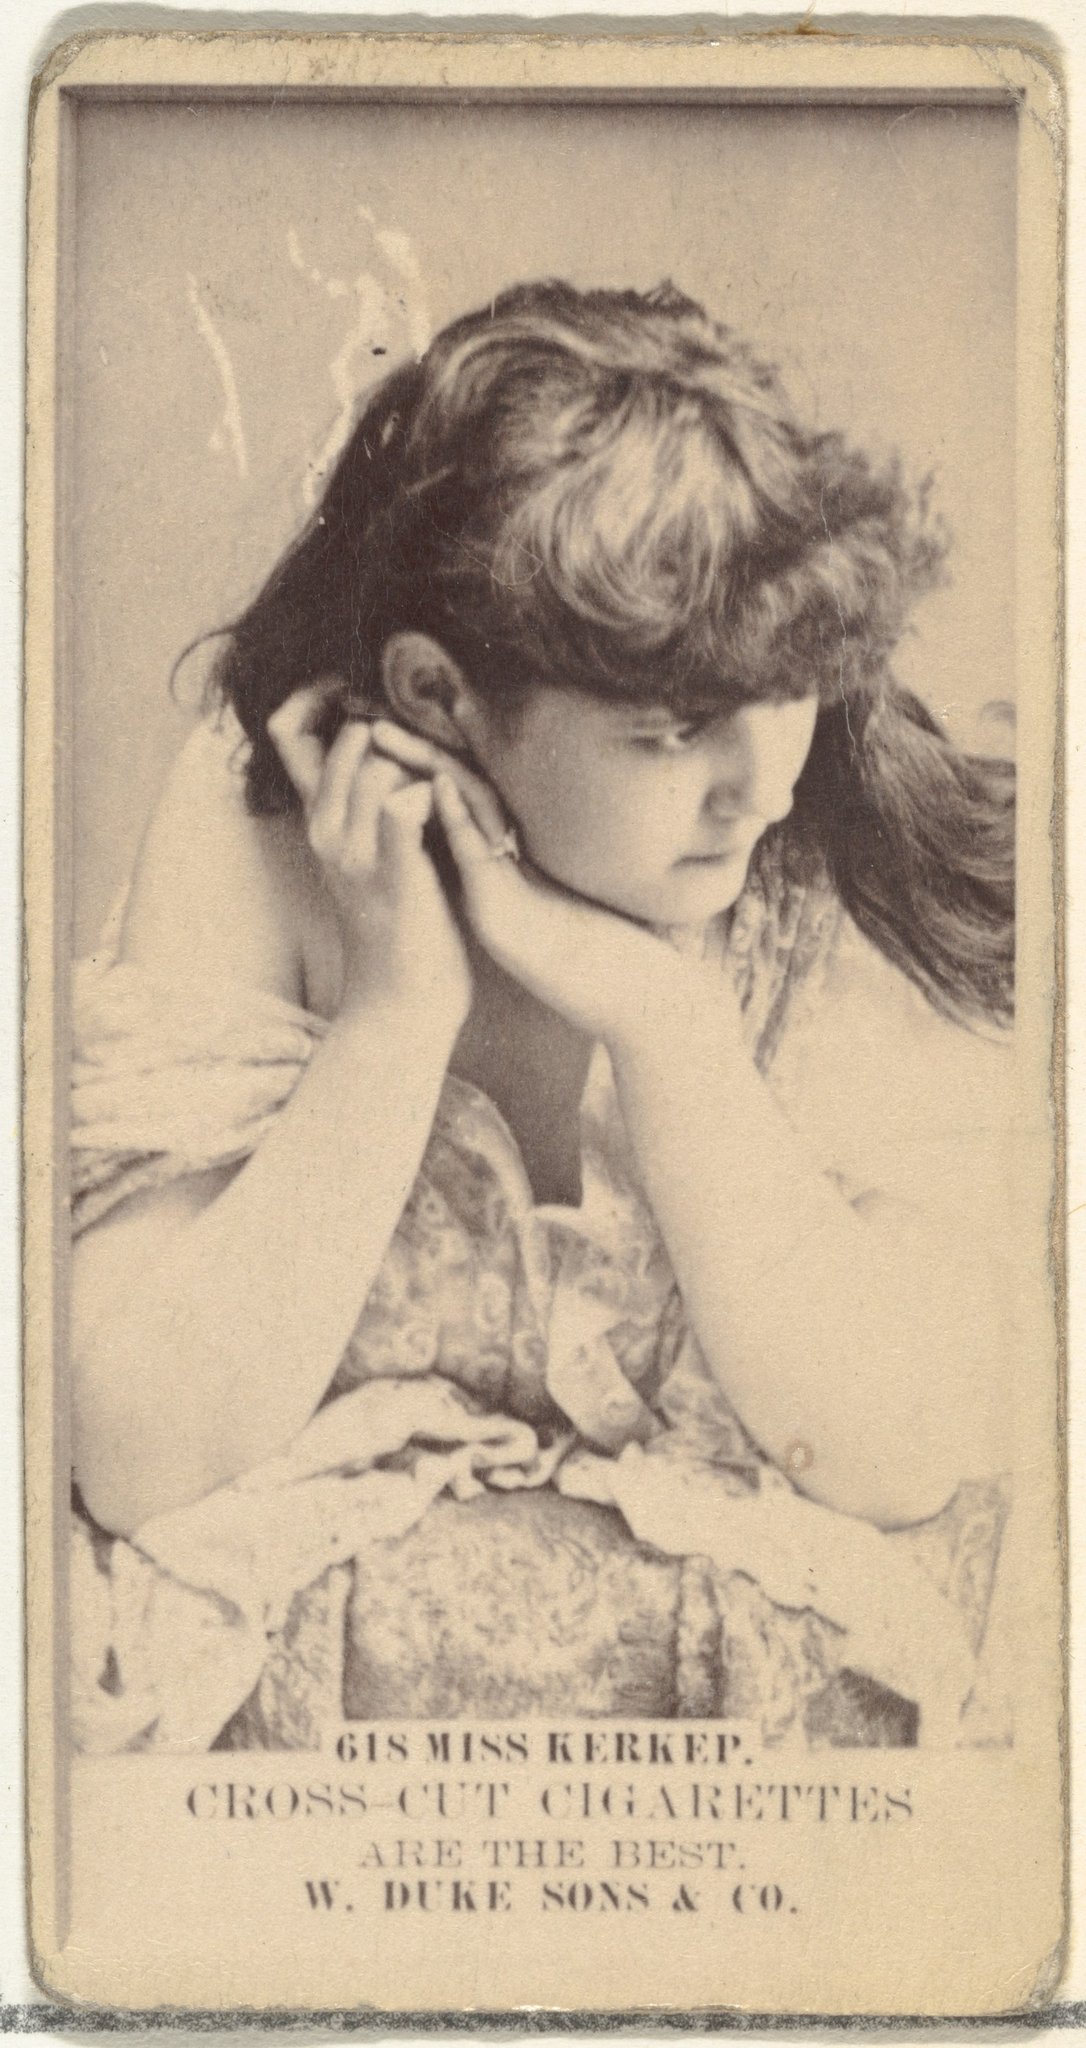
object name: photograph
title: Card Number 618, Miss Kerkep, from the Actors and Actresses series (N145-3) issued by Duke Sons & Co. to promote Cross Cut Cigarettes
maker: w. duke, sons & co.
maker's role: publisher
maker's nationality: american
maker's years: 1870-1920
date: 1880-1889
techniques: albumen silver print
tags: portraits,women,actresses